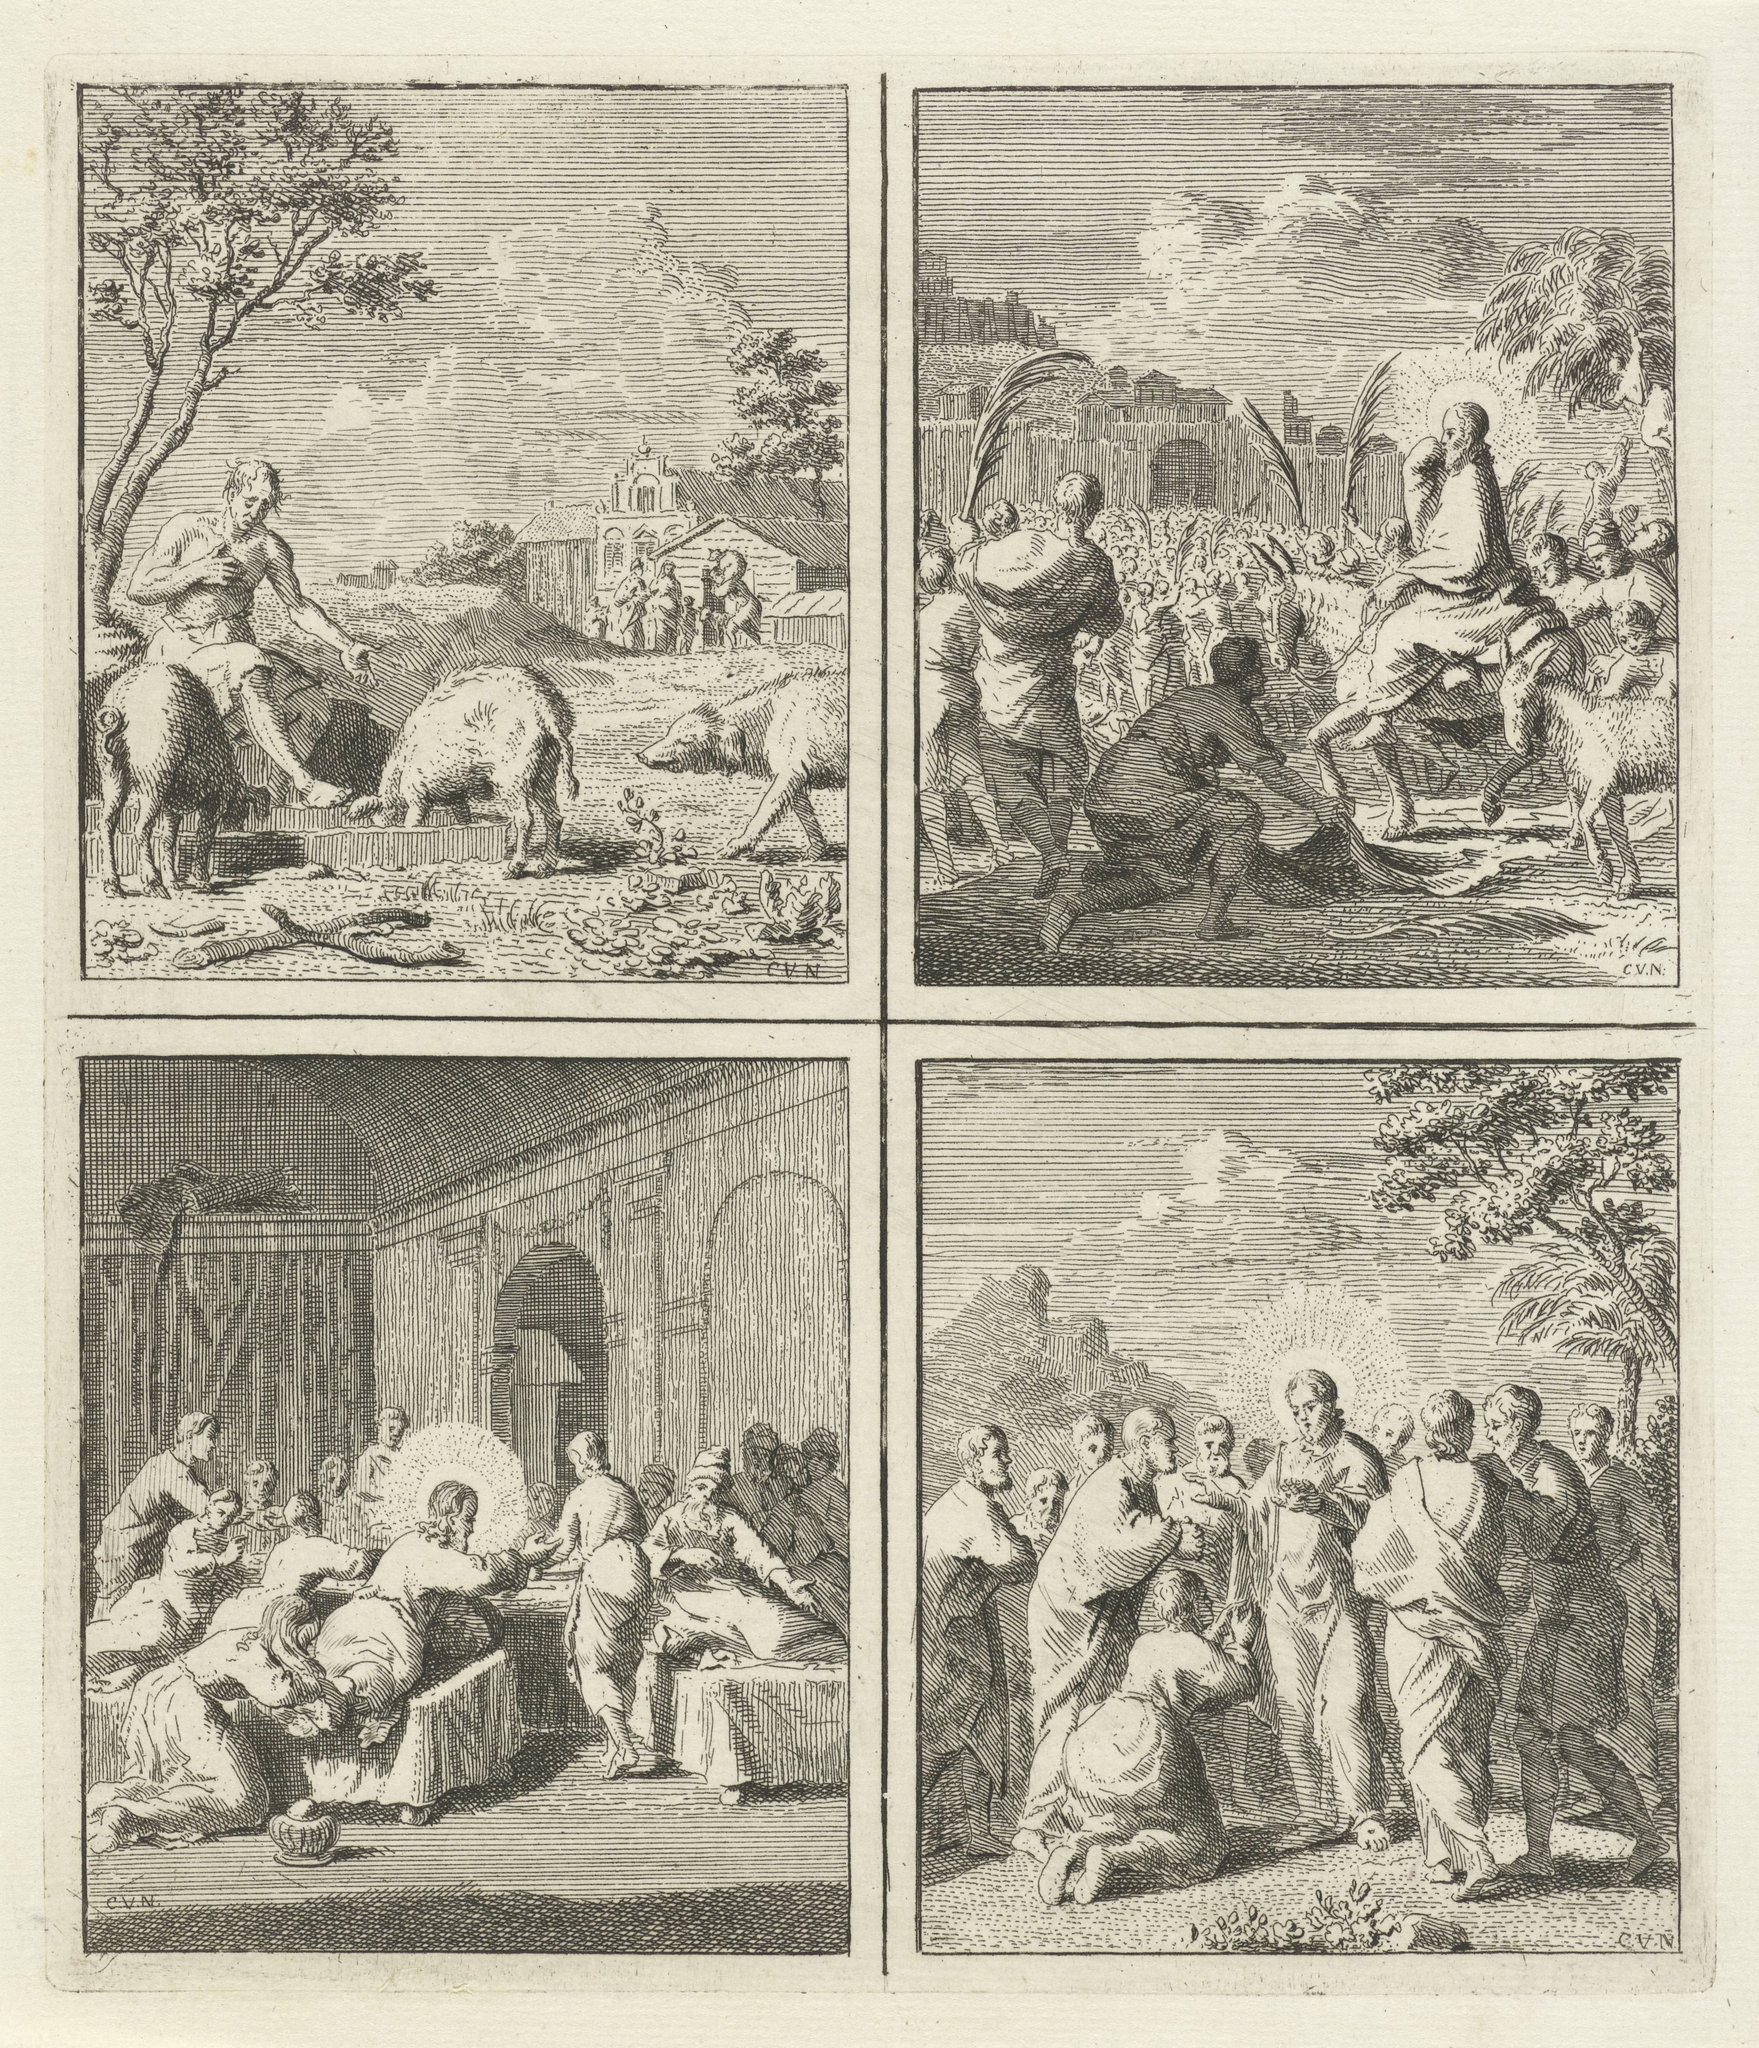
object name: print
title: Verloren zoon / Intocht van Christus in Jeruzalem / Maria Magdalena zalft de voeten van Christus / Uitzending van de discipelen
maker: cornelis van noorde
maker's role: draughtsman, print maker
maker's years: 1731-1795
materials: paper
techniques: etching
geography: haarlem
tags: christ showing his wounds to the apostles, christ's feet are anointed by mary (magdalene), the prodigal son tends the swine and eats from their trough, entry into jerusalem: people spreading their clothes before christ on the ass, and waving palm branches (matthew 21:1-11, 21:14-16; mark 11:1-11; luke 19:28-40; john 12:12-19)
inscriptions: collector's mark: Lugt 240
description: Vier voorstellingen. Linksboven: de verloren zoon bij de varkens. Rechtsboven: Christus rijdt op een ezel Jeruzalem binnen, terwijl de mensen met palmtakken wuiven en hun mantels voor hem op de grond leggen. Linksonder: Maria Magdalena zalft de voeten van Christus en droogt ze met haar haren. Rechtsonder: de opgestane Christus zendt zijn discipelen uit.